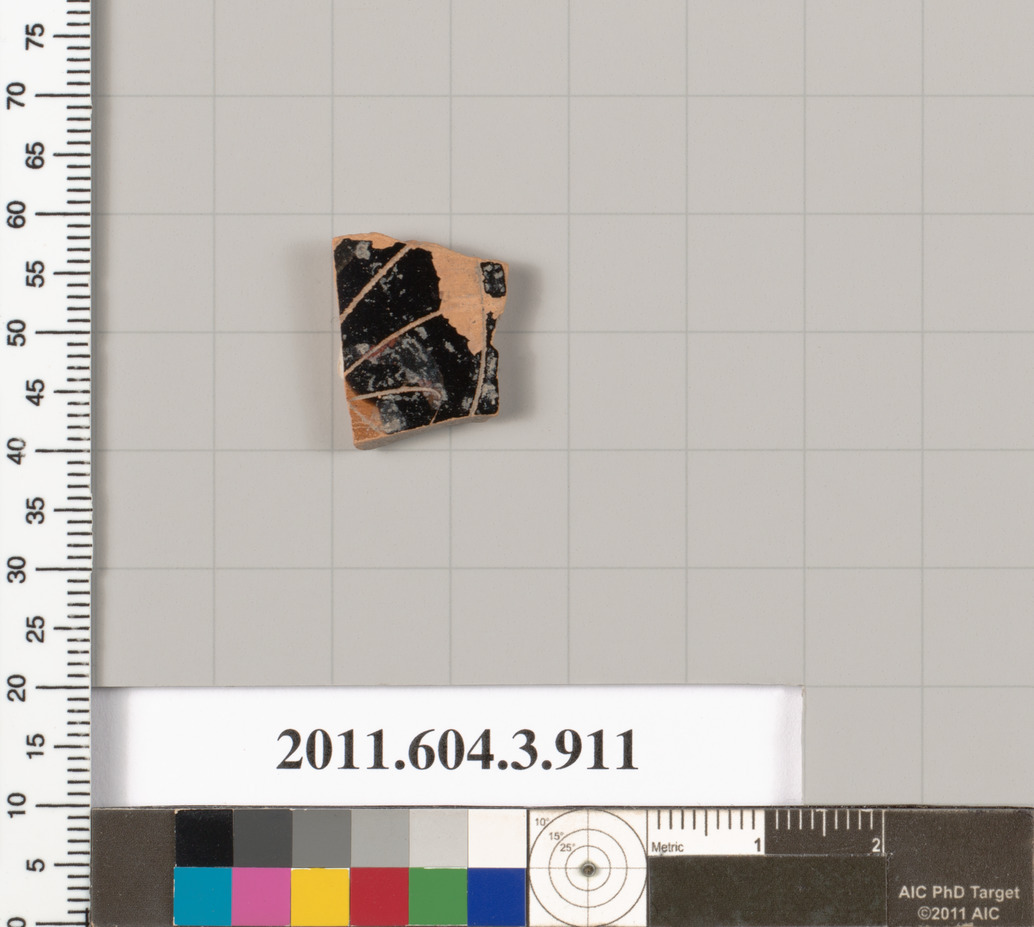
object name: lekythos fragment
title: Terracotta fragment of a lekythos (oil flask)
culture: greek, attic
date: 534-468 BCE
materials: terracotta